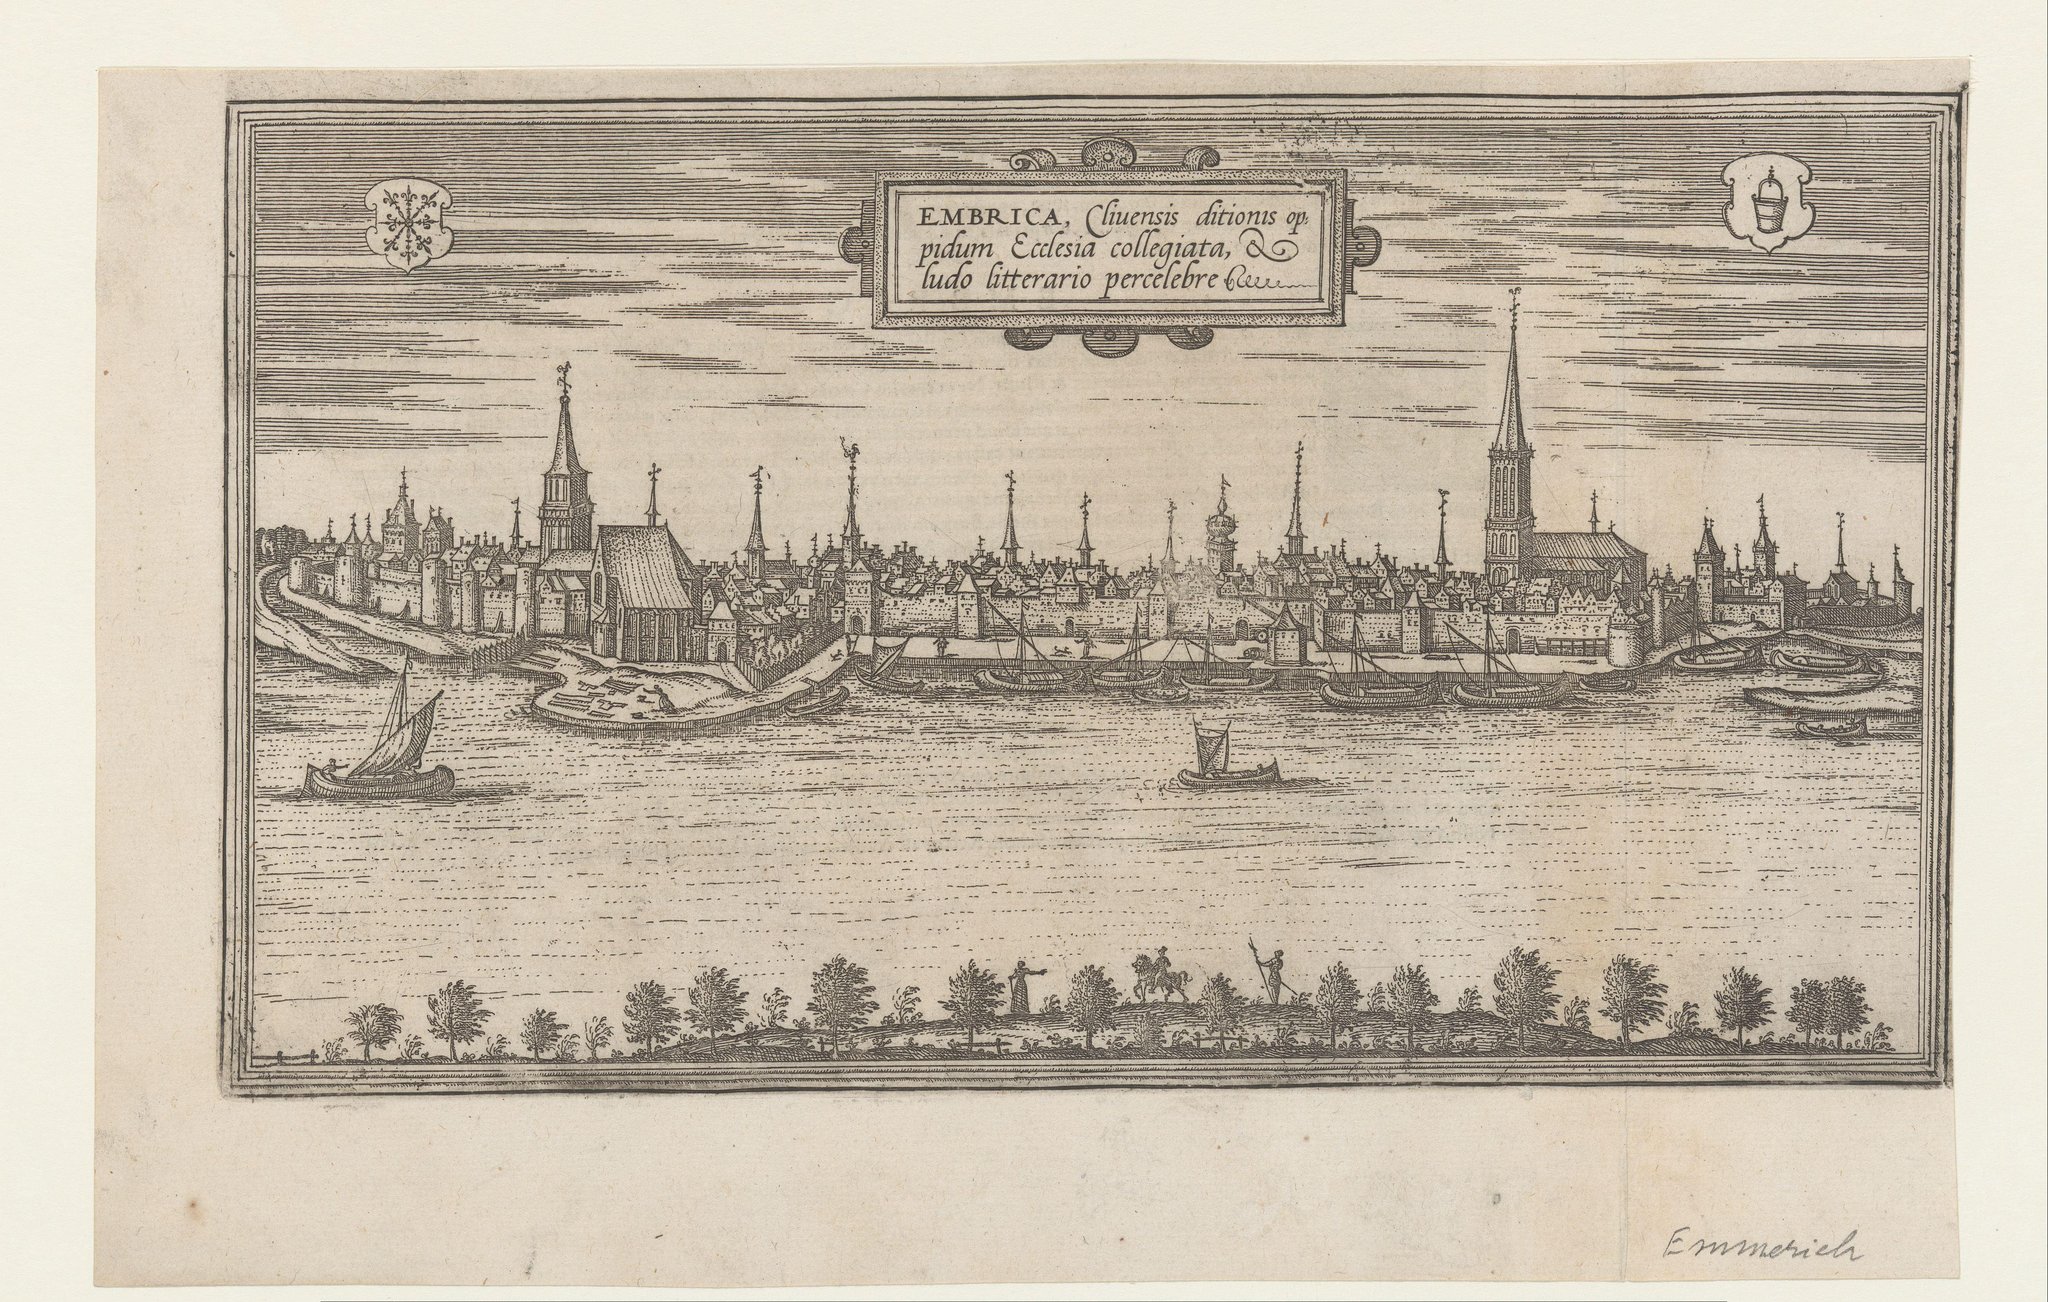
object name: print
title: Embrica, Clivensis ditionis oppidum ecclesia collegiata (...)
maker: Anonymous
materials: paper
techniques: etching, letterpress printing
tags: coat of arms (as symbol of the state, etc.) (+ city; municipal), coat of arms (as symbol of the state, etc.) (+ province; provincial), prospect of city, town panorama, silhouette of city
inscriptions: collector's mark: Lugt 2228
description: Prent is gedrukt van dezelfde plaat als een gezicht op Kleve, Emmerik en Gennep, maar is hiervan afgesneden. Het blad met deze drie prenten is vanaf 1575 gebruikt in Braun & Hogenbergs 'Civitates Orbis Terrarum'.